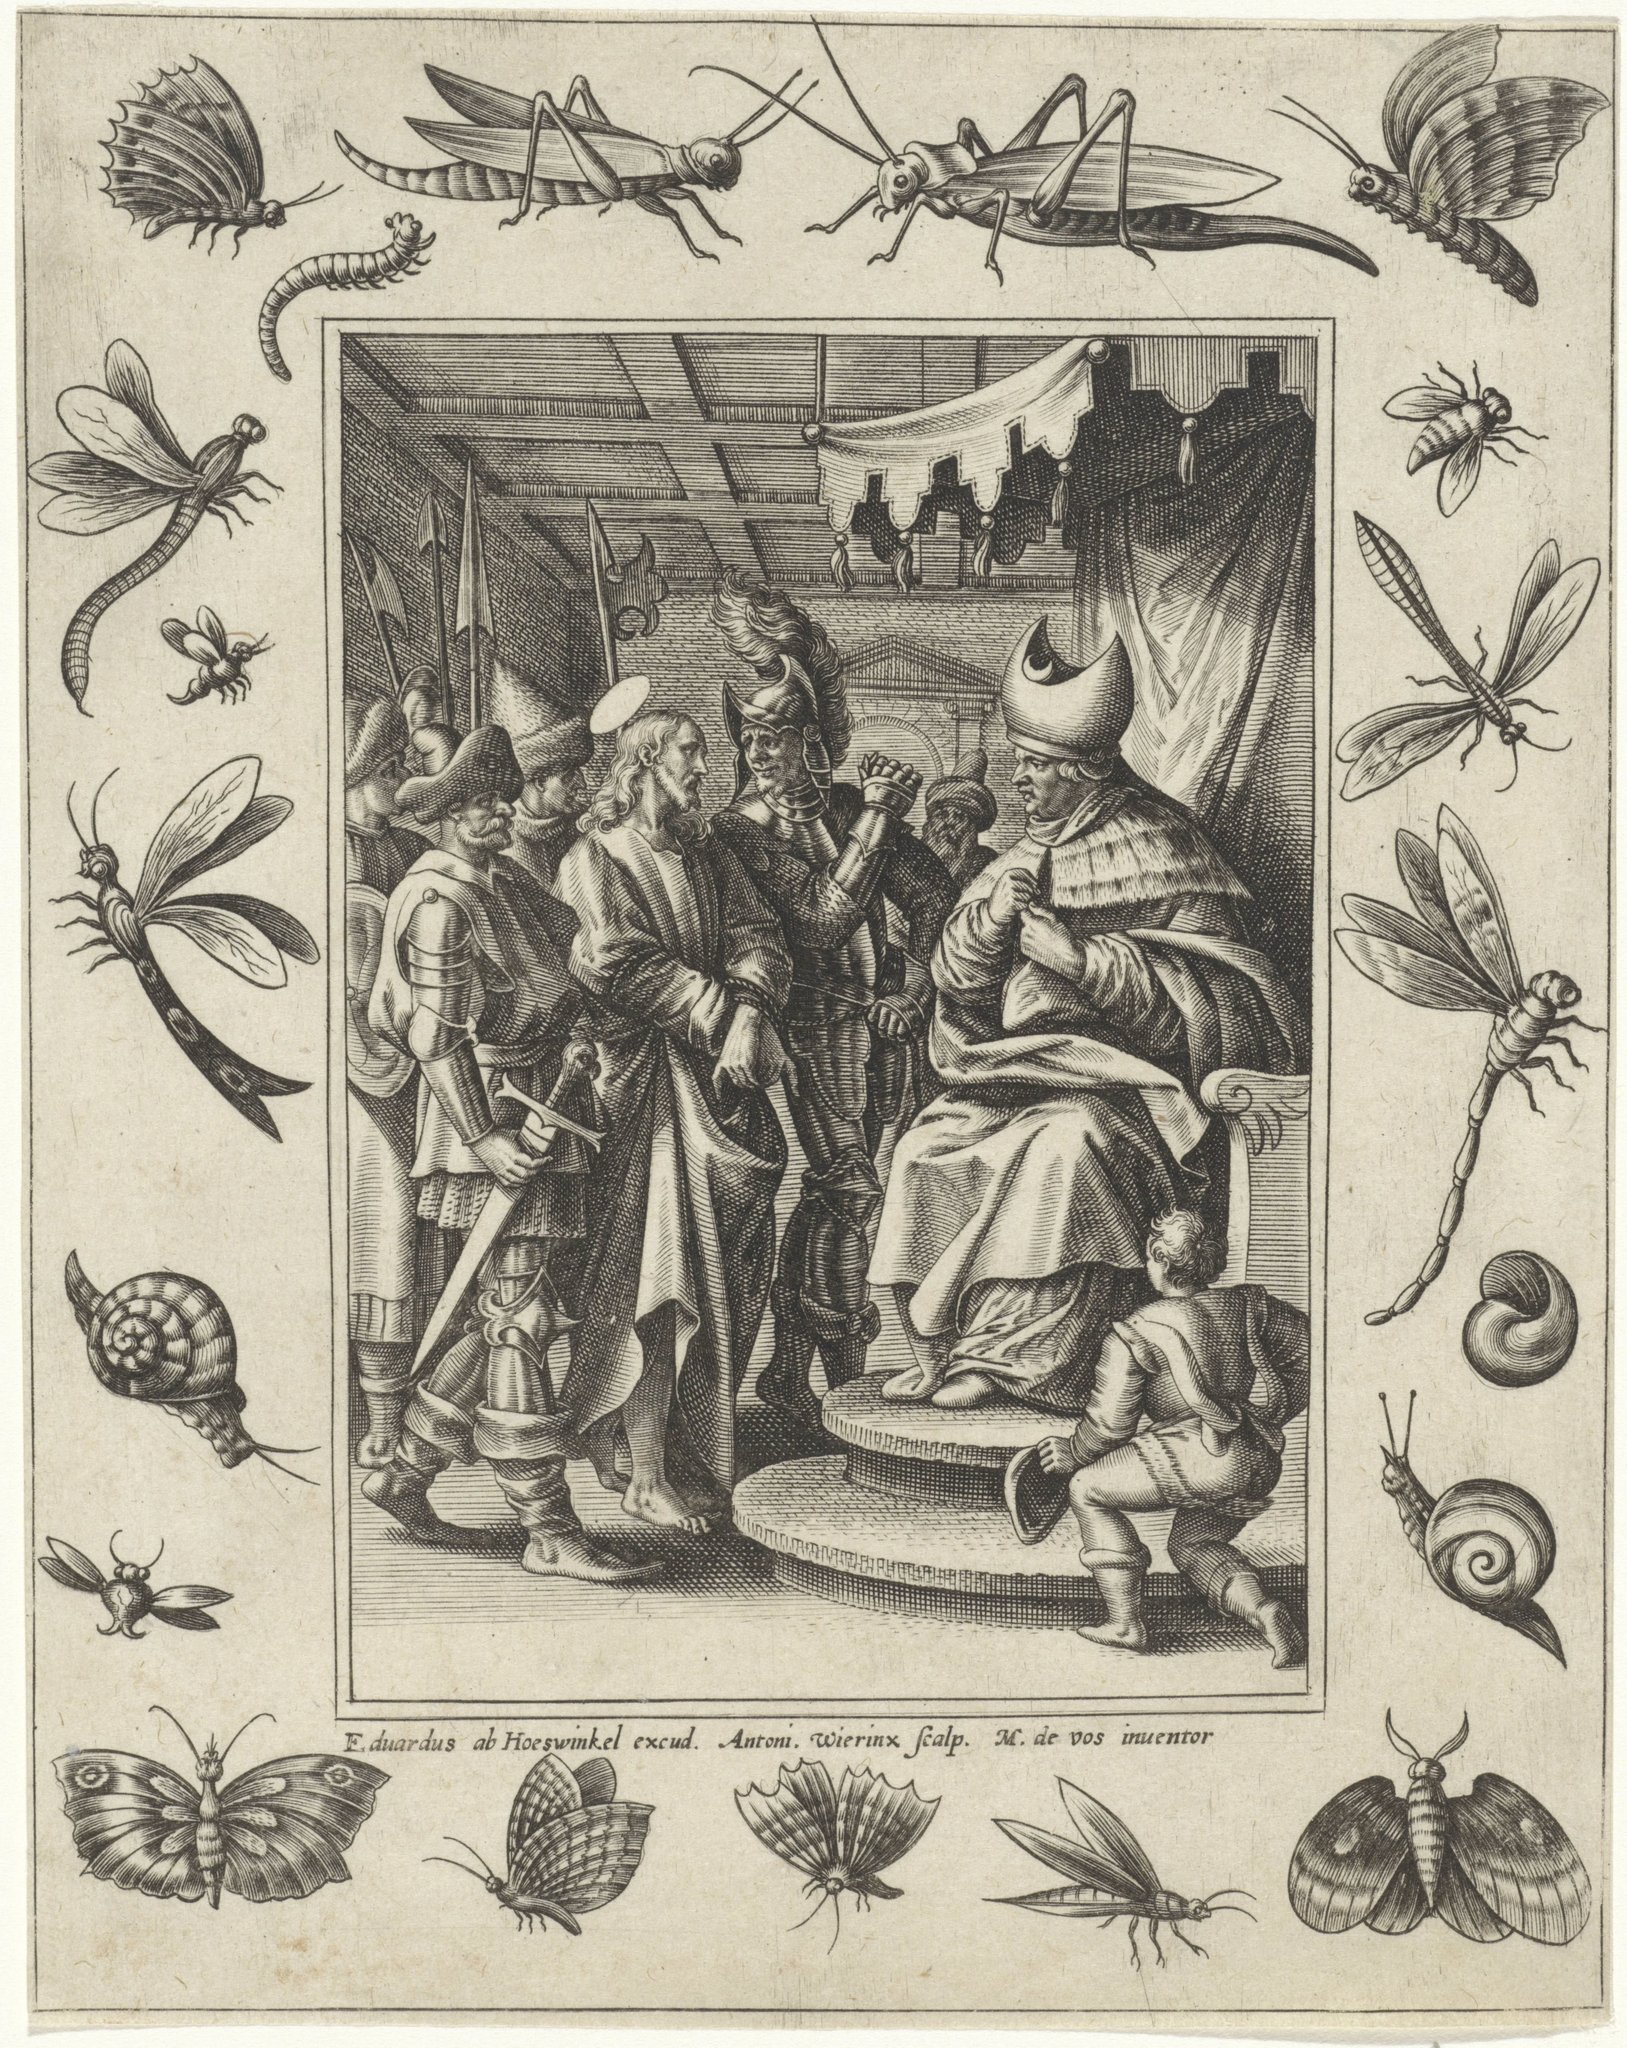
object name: print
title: Christus voor Kajafas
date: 1582-1586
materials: paper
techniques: engraving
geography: antwerp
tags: caiaphas tearing his clothes ~ trial of christ, insects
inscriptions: collector's mark: Lugt 2228, collector's mark: Lugt 2760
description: Christus wordt berecht door Kajafas. Soldaten brengen hem geboeid naar de hogepriester. Kajafas scheurt zijn gewaad en beschuldigt Christus van godslastering. De voorstelling is gevat in een ornamentele omlijsting die is gedecoreerd met verschillende insecten.